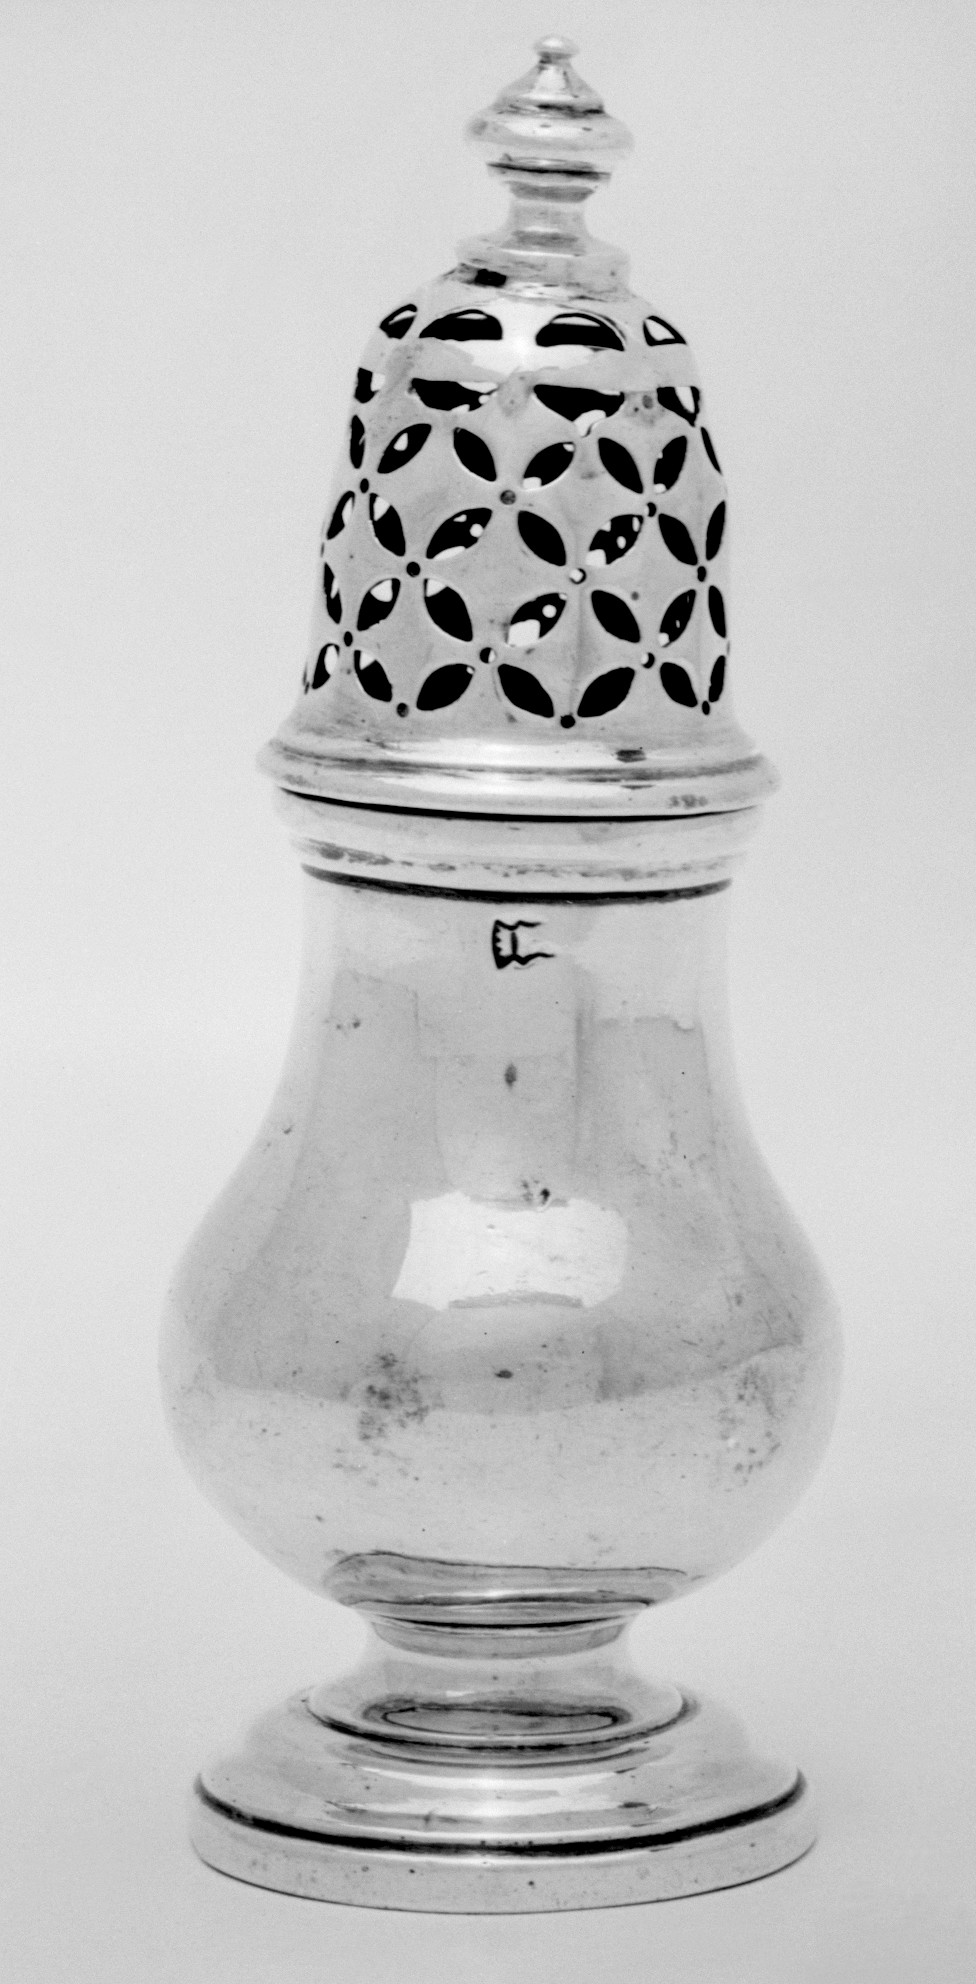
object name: caster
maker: reynier brandt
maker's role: maker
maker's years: 1734-1788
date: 1756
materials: silver